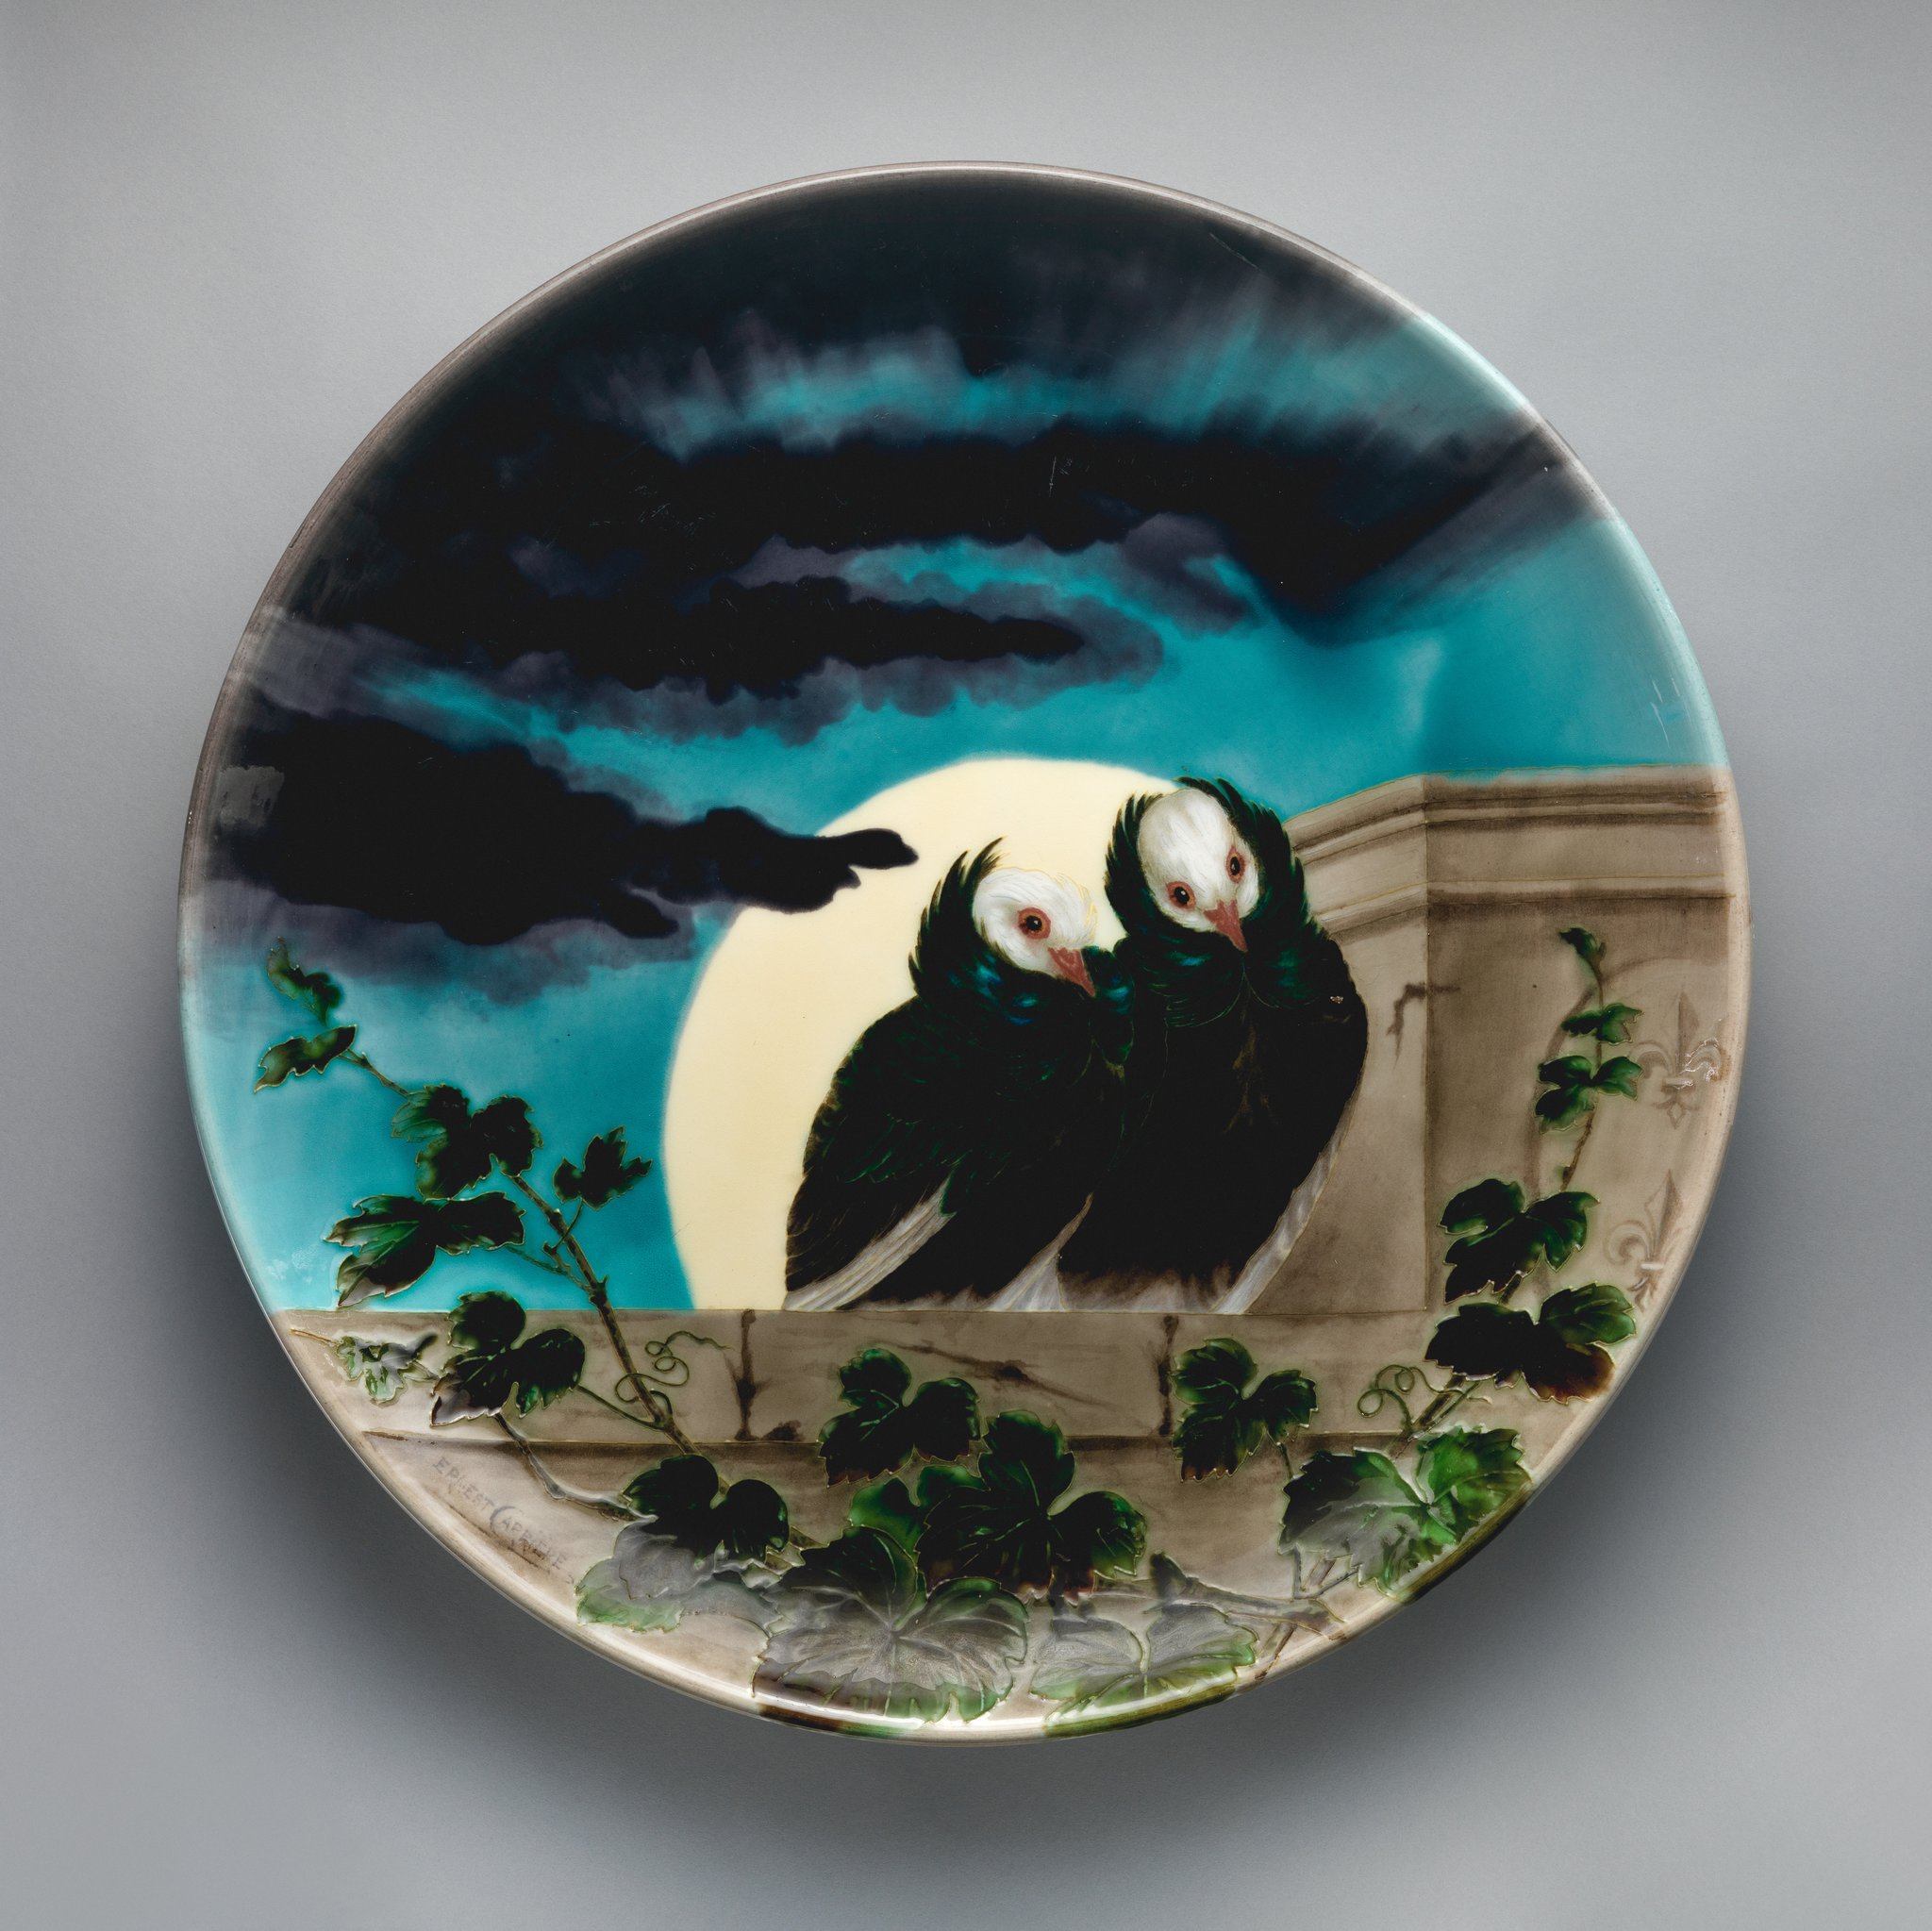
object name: charger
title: Charger with birds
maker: joseph-théodore deck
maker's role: maker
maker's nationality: french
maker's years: 1823-1891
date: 1885-1890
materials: earthenware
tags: birds